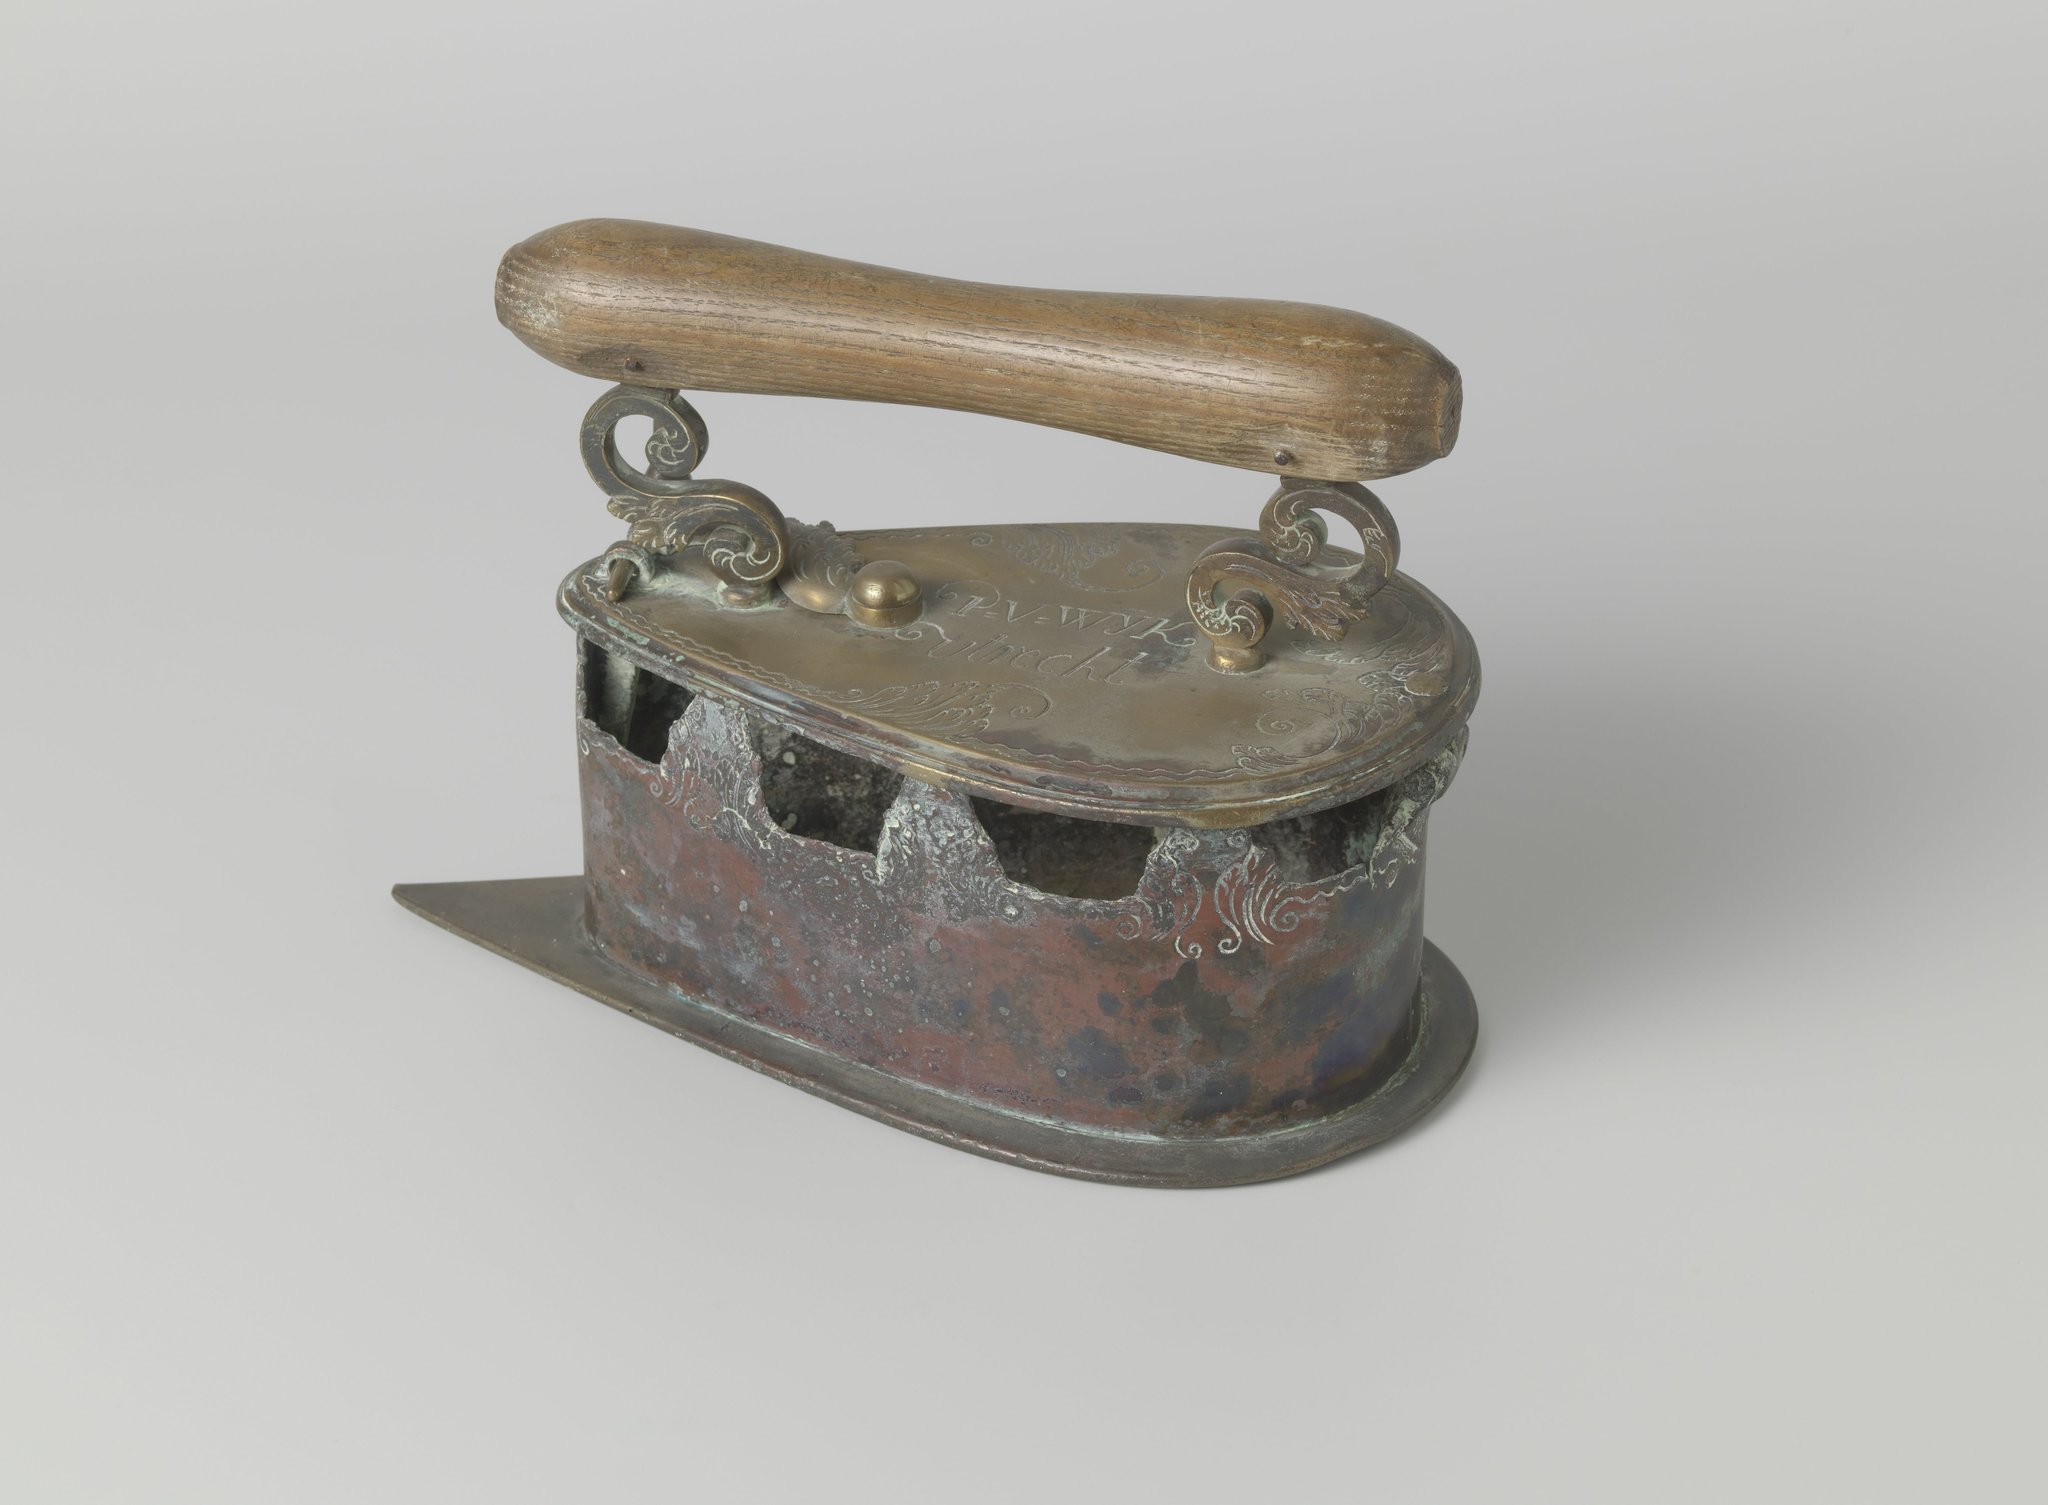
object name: iron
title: Strijkijzer van koper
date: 1600-1699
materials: copper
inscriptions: name: ‘P=V=Wijk’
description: Gegraveerd met voorstellingen (?) en 'P. van Wijk Utrecht'.